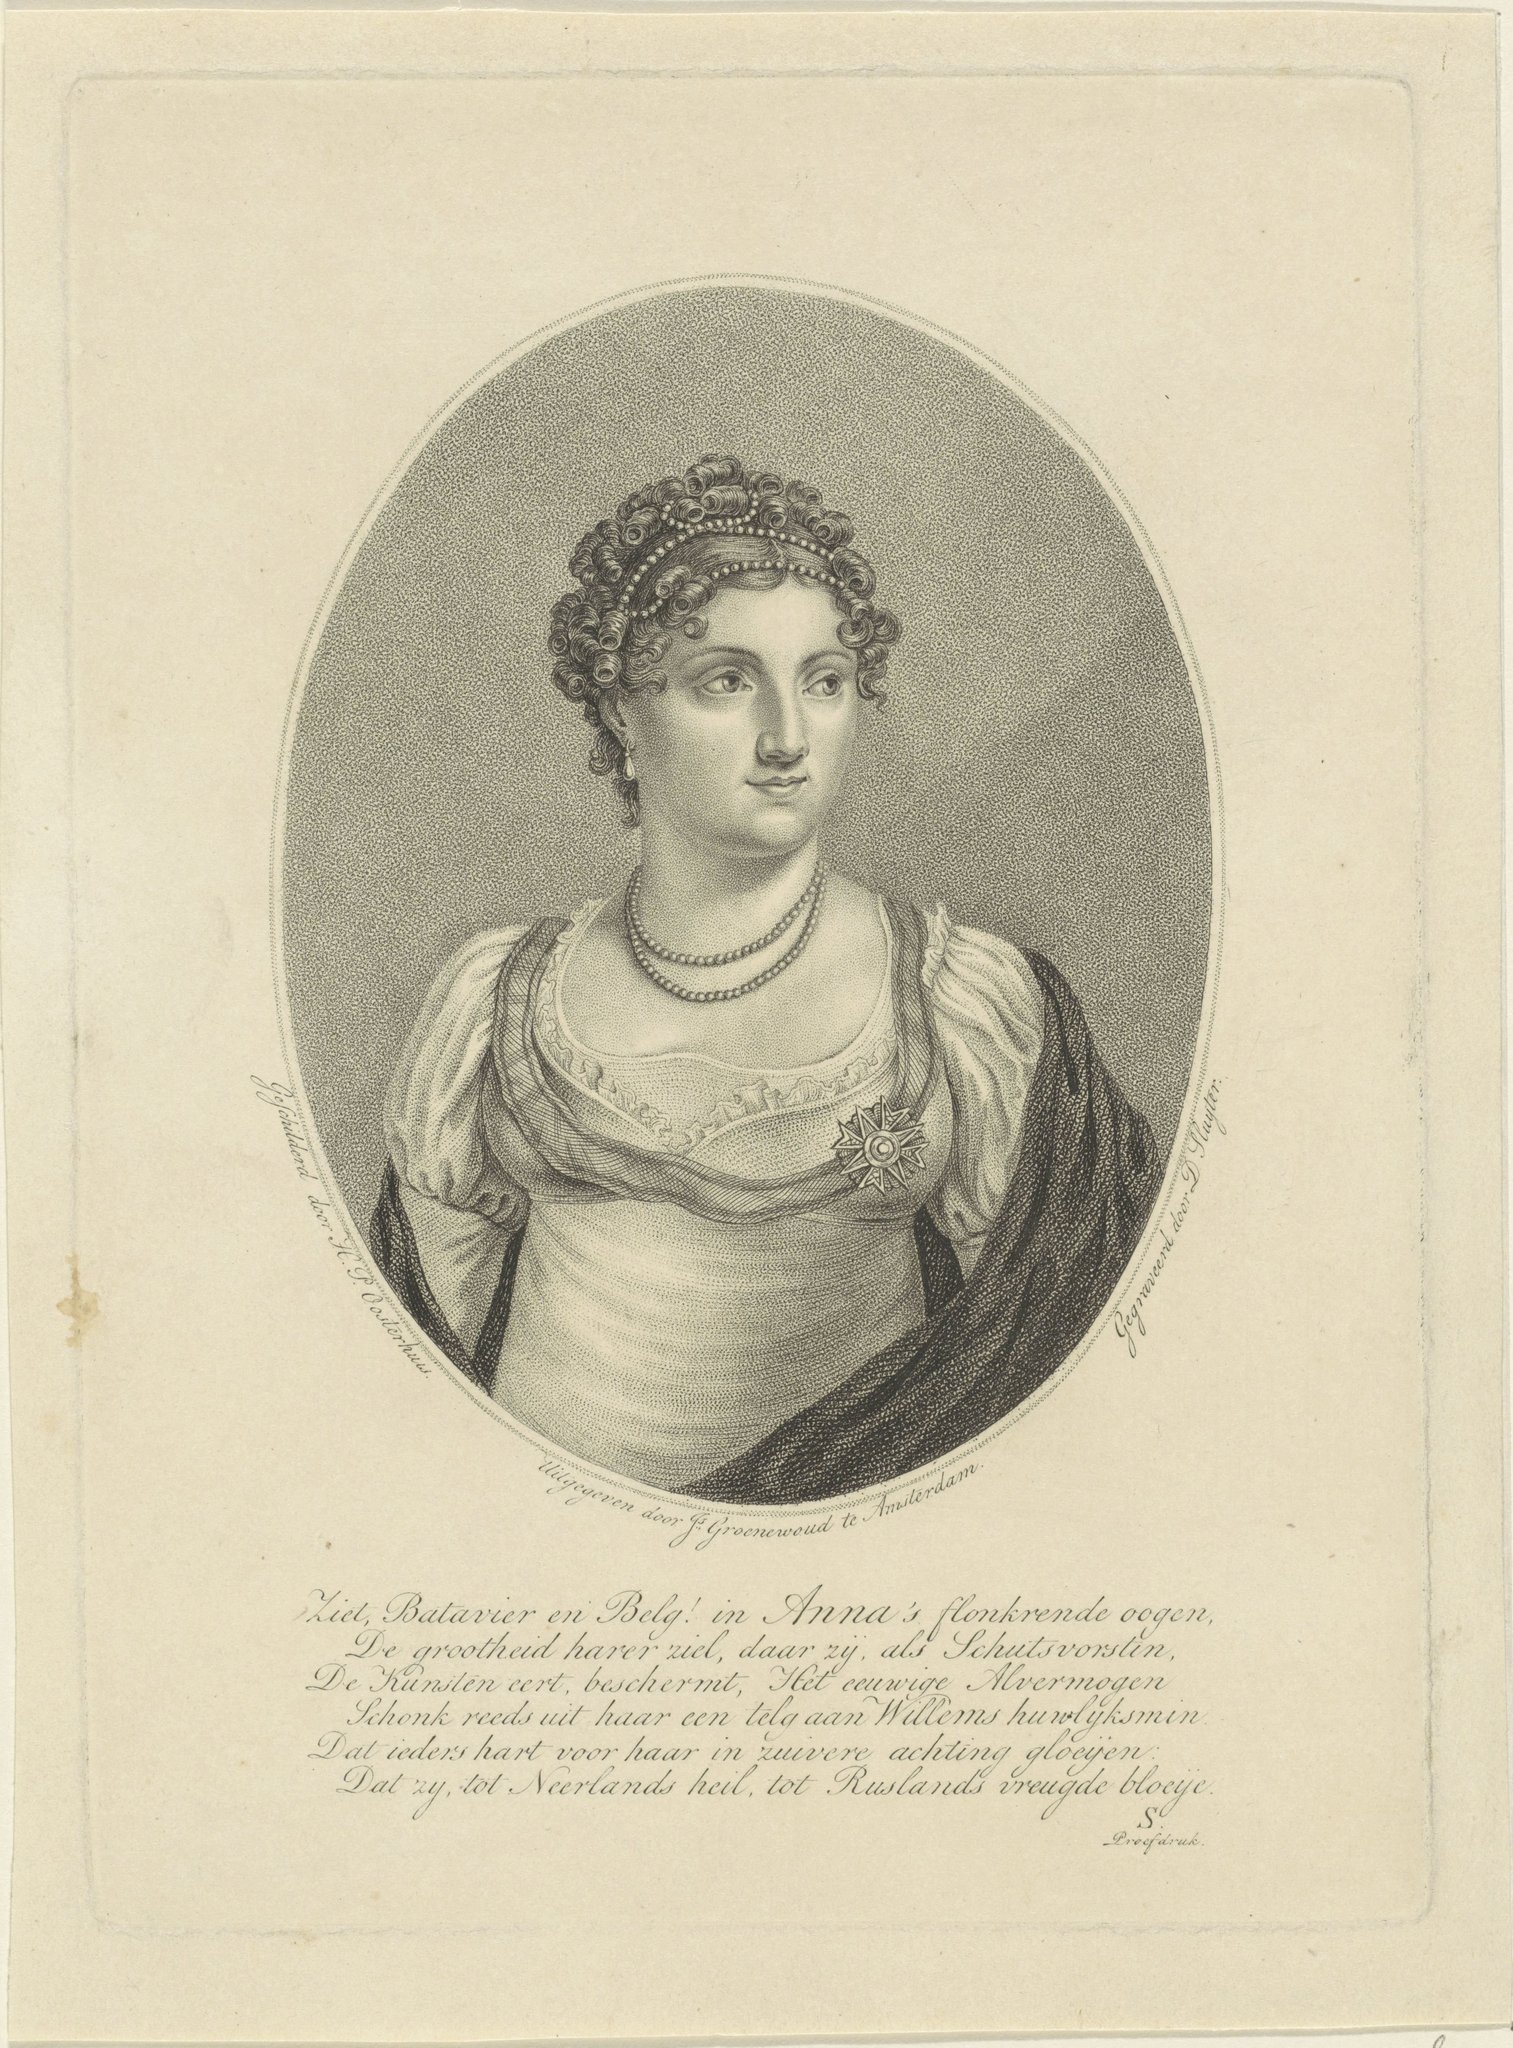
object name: print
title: Portret van Anna Paulowna Romanowa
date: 1816-1819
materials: paper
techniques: engraving, etching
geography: amsterdam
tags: the hague, anna paulowna romanowa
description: Portret van Anna Paulowna in een ovaal. In de ondermarge zes regels Nederlandse tekst. Rechtsonder 'Proefdruk.'.